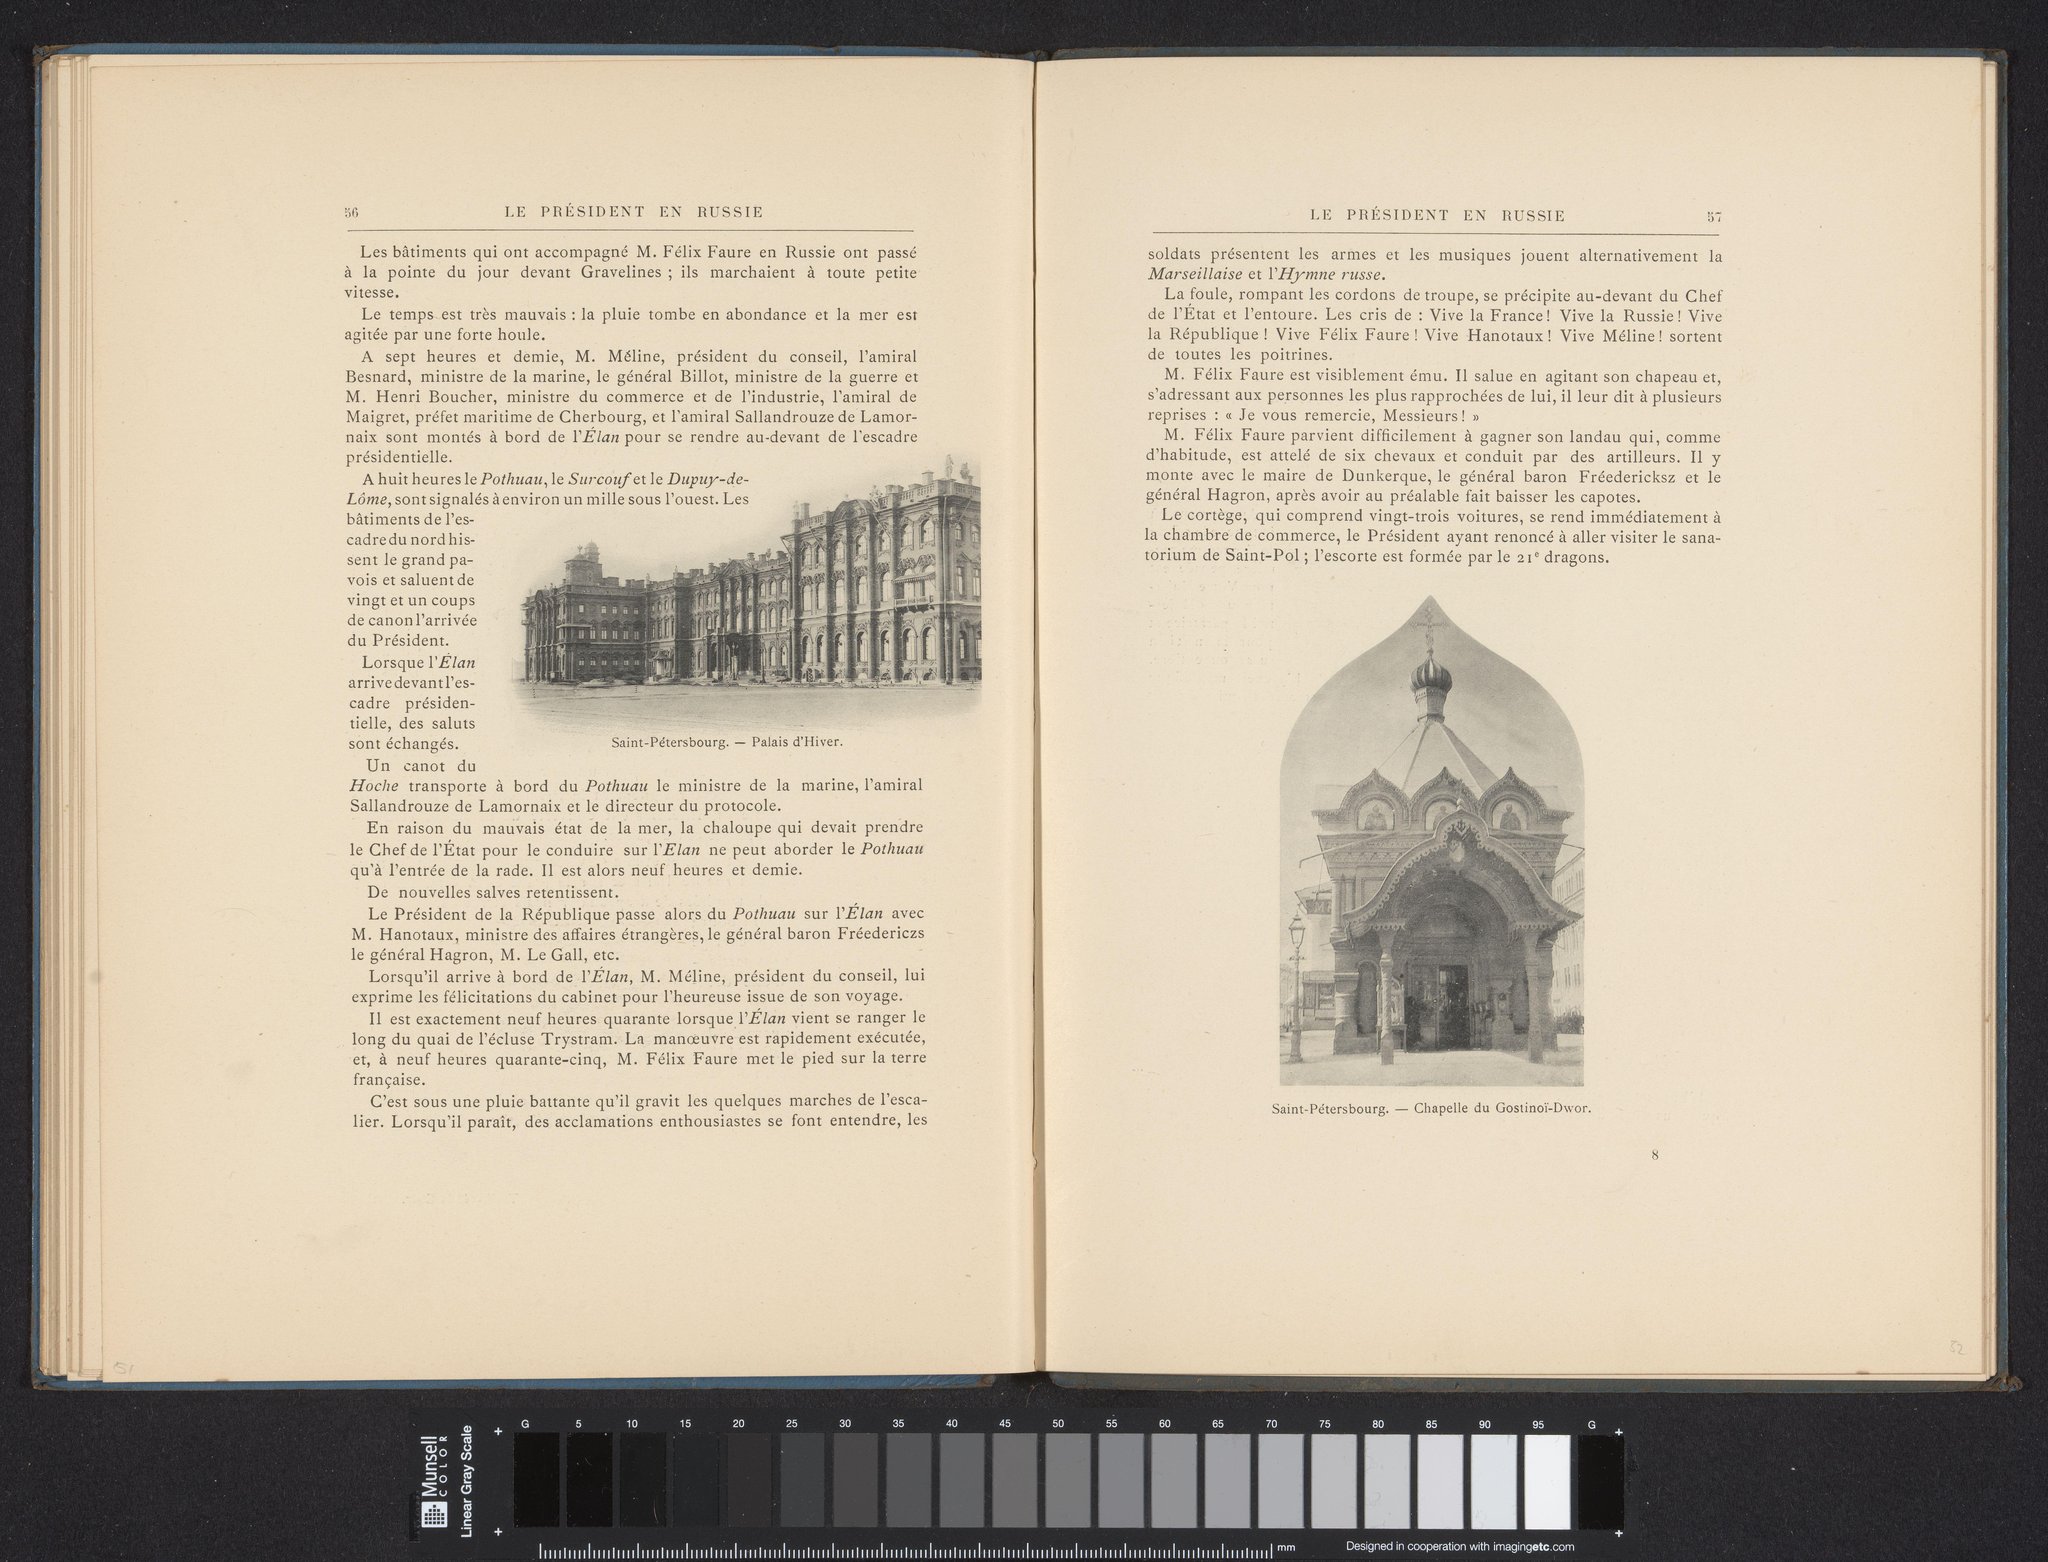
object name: photomechanical print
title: Kapel van de Gostiny Dvor te Sint-Petersburg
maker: Anonymous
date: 1897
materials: paper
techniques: photograph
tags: parts of church exterior and annexes: chapel, façade (of house or building)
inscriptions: inscription: ‘Saint-Pétersbourg.- Chapelle du Gostinoï-Dwor.’